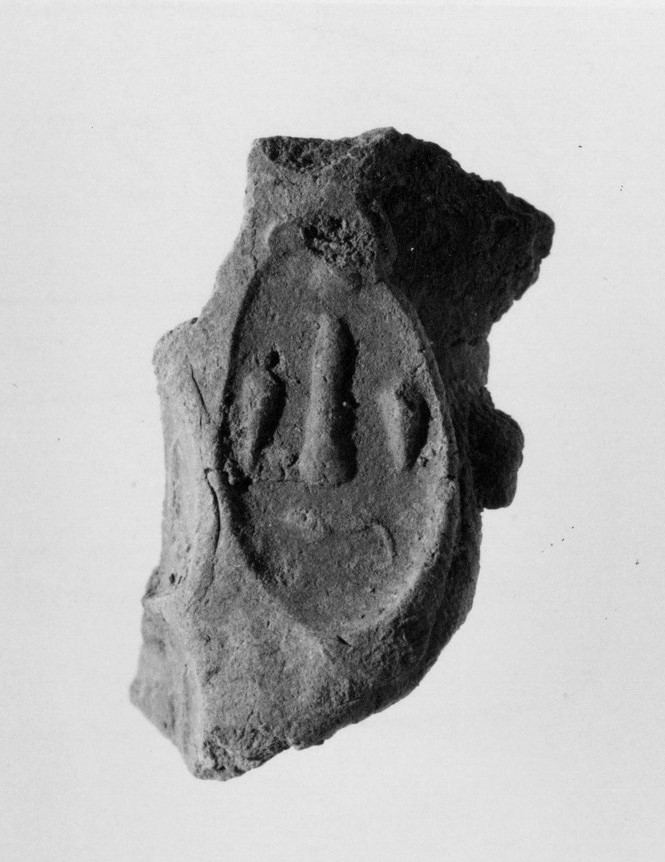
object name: sealing, djed, cobra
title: Document Sealing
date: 1390-1352 BCE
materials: mud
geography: egypt